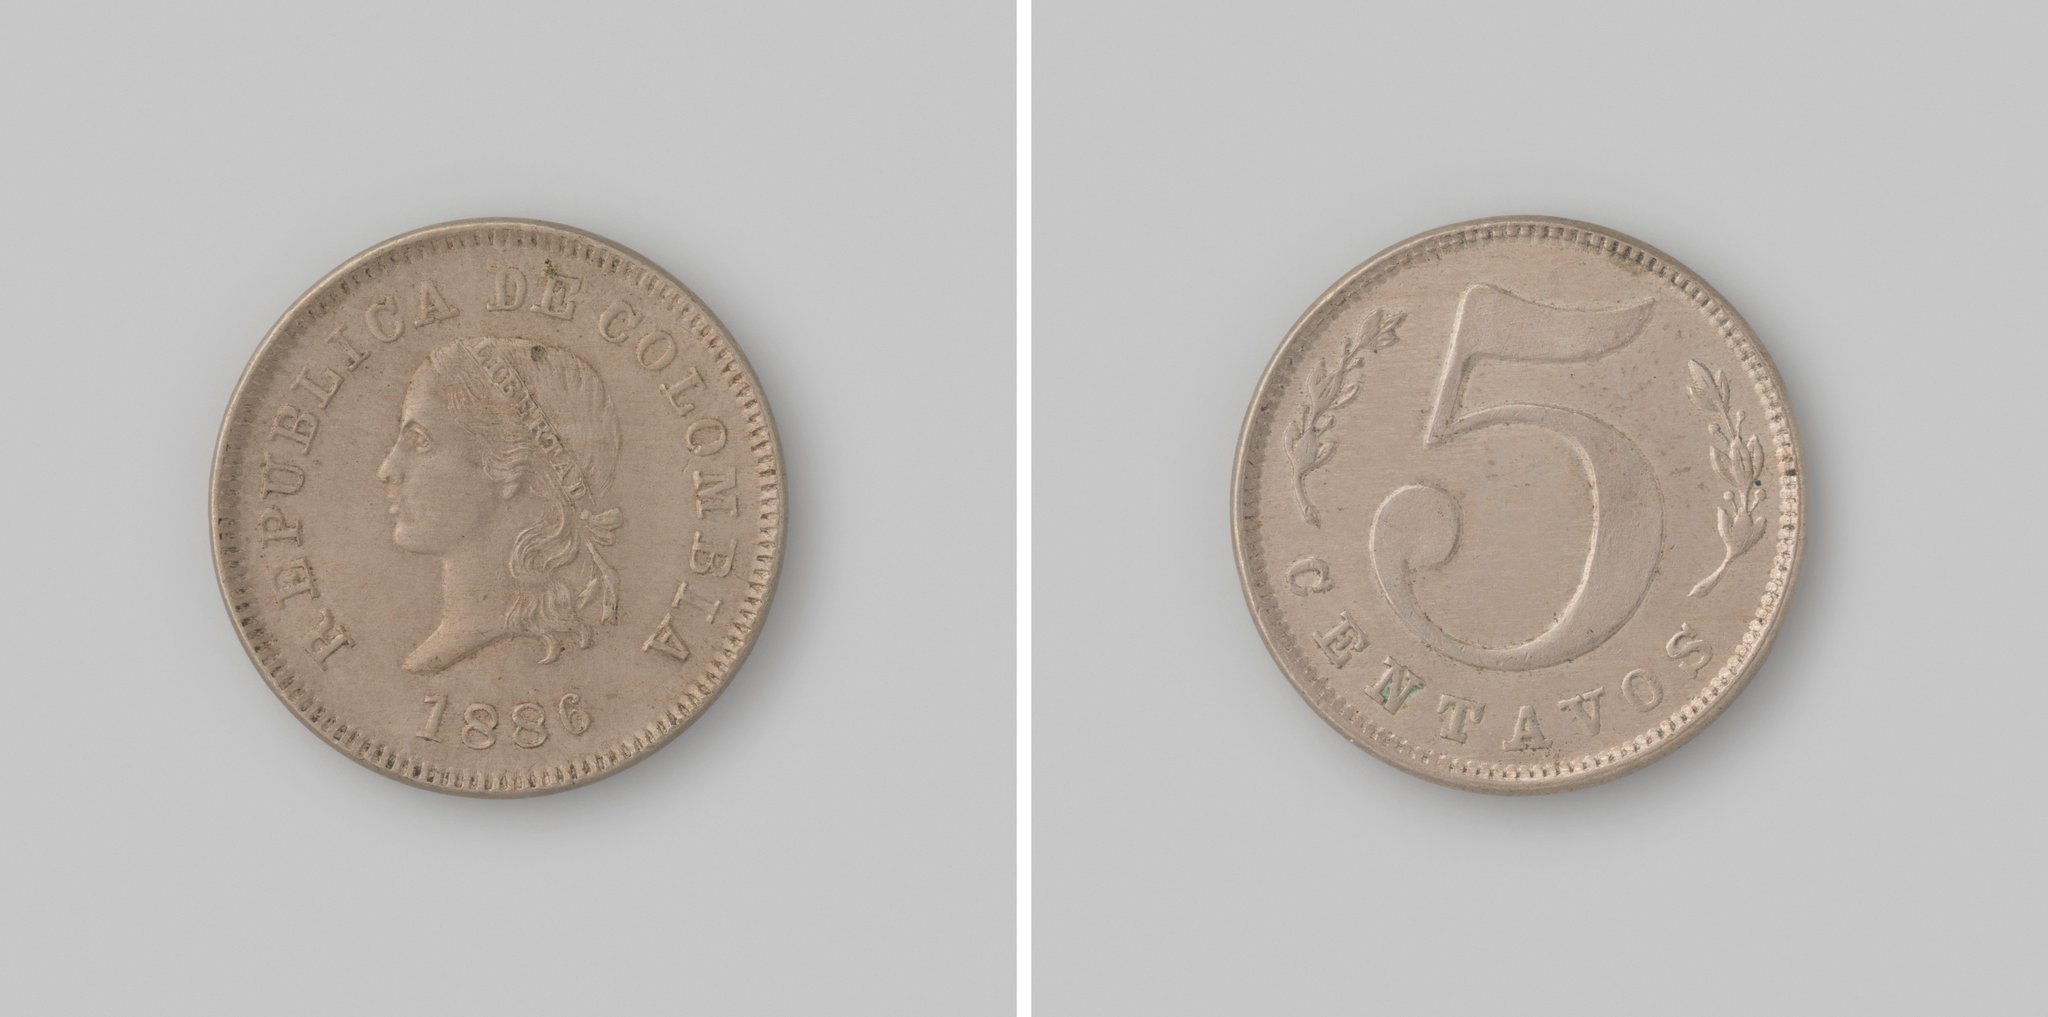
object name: coin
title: 5 centavos uit Colombia, 1886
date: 1886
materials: nickel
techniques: striking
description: Koper-nikkelen munt. Voorzijde: borstbeeld van een vrouw met hoofdband, waarop opschrift: Libertad. Jaartal onderaan. Keerzijde: tussen twee takken waarde-aanduiding in twee regels. Gladde rand.